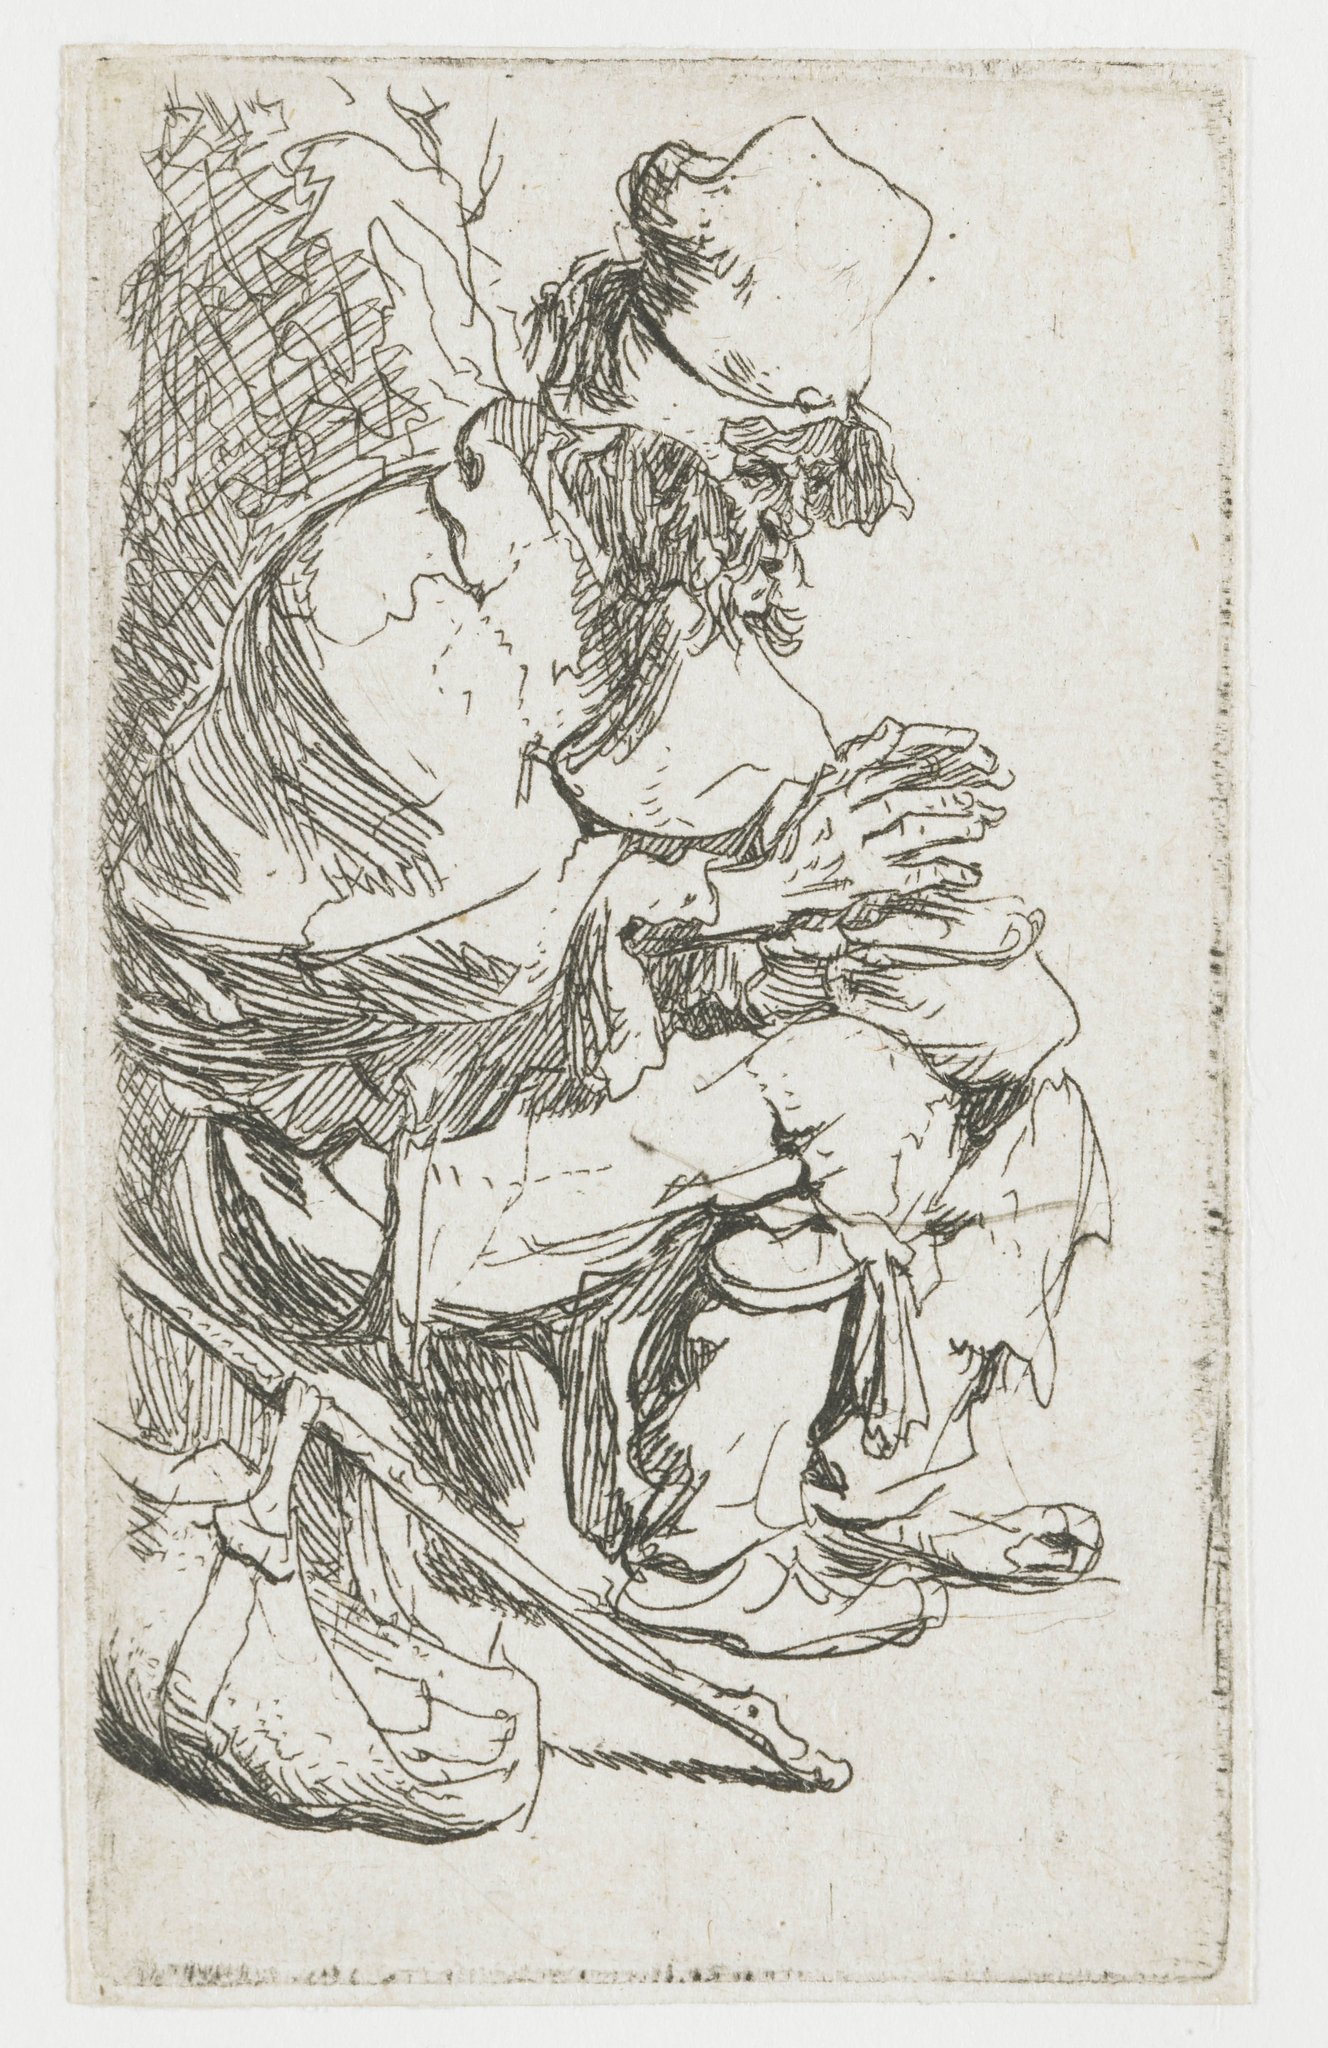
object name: print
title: Beggar seated warming his hands at a chafing dish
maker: rembrandt van rijn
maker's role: draughtsman, painter, print maker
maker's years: 1606-1669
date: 1630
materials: paper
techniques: etching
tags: beggar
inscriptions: collector's mark: Lugt 240